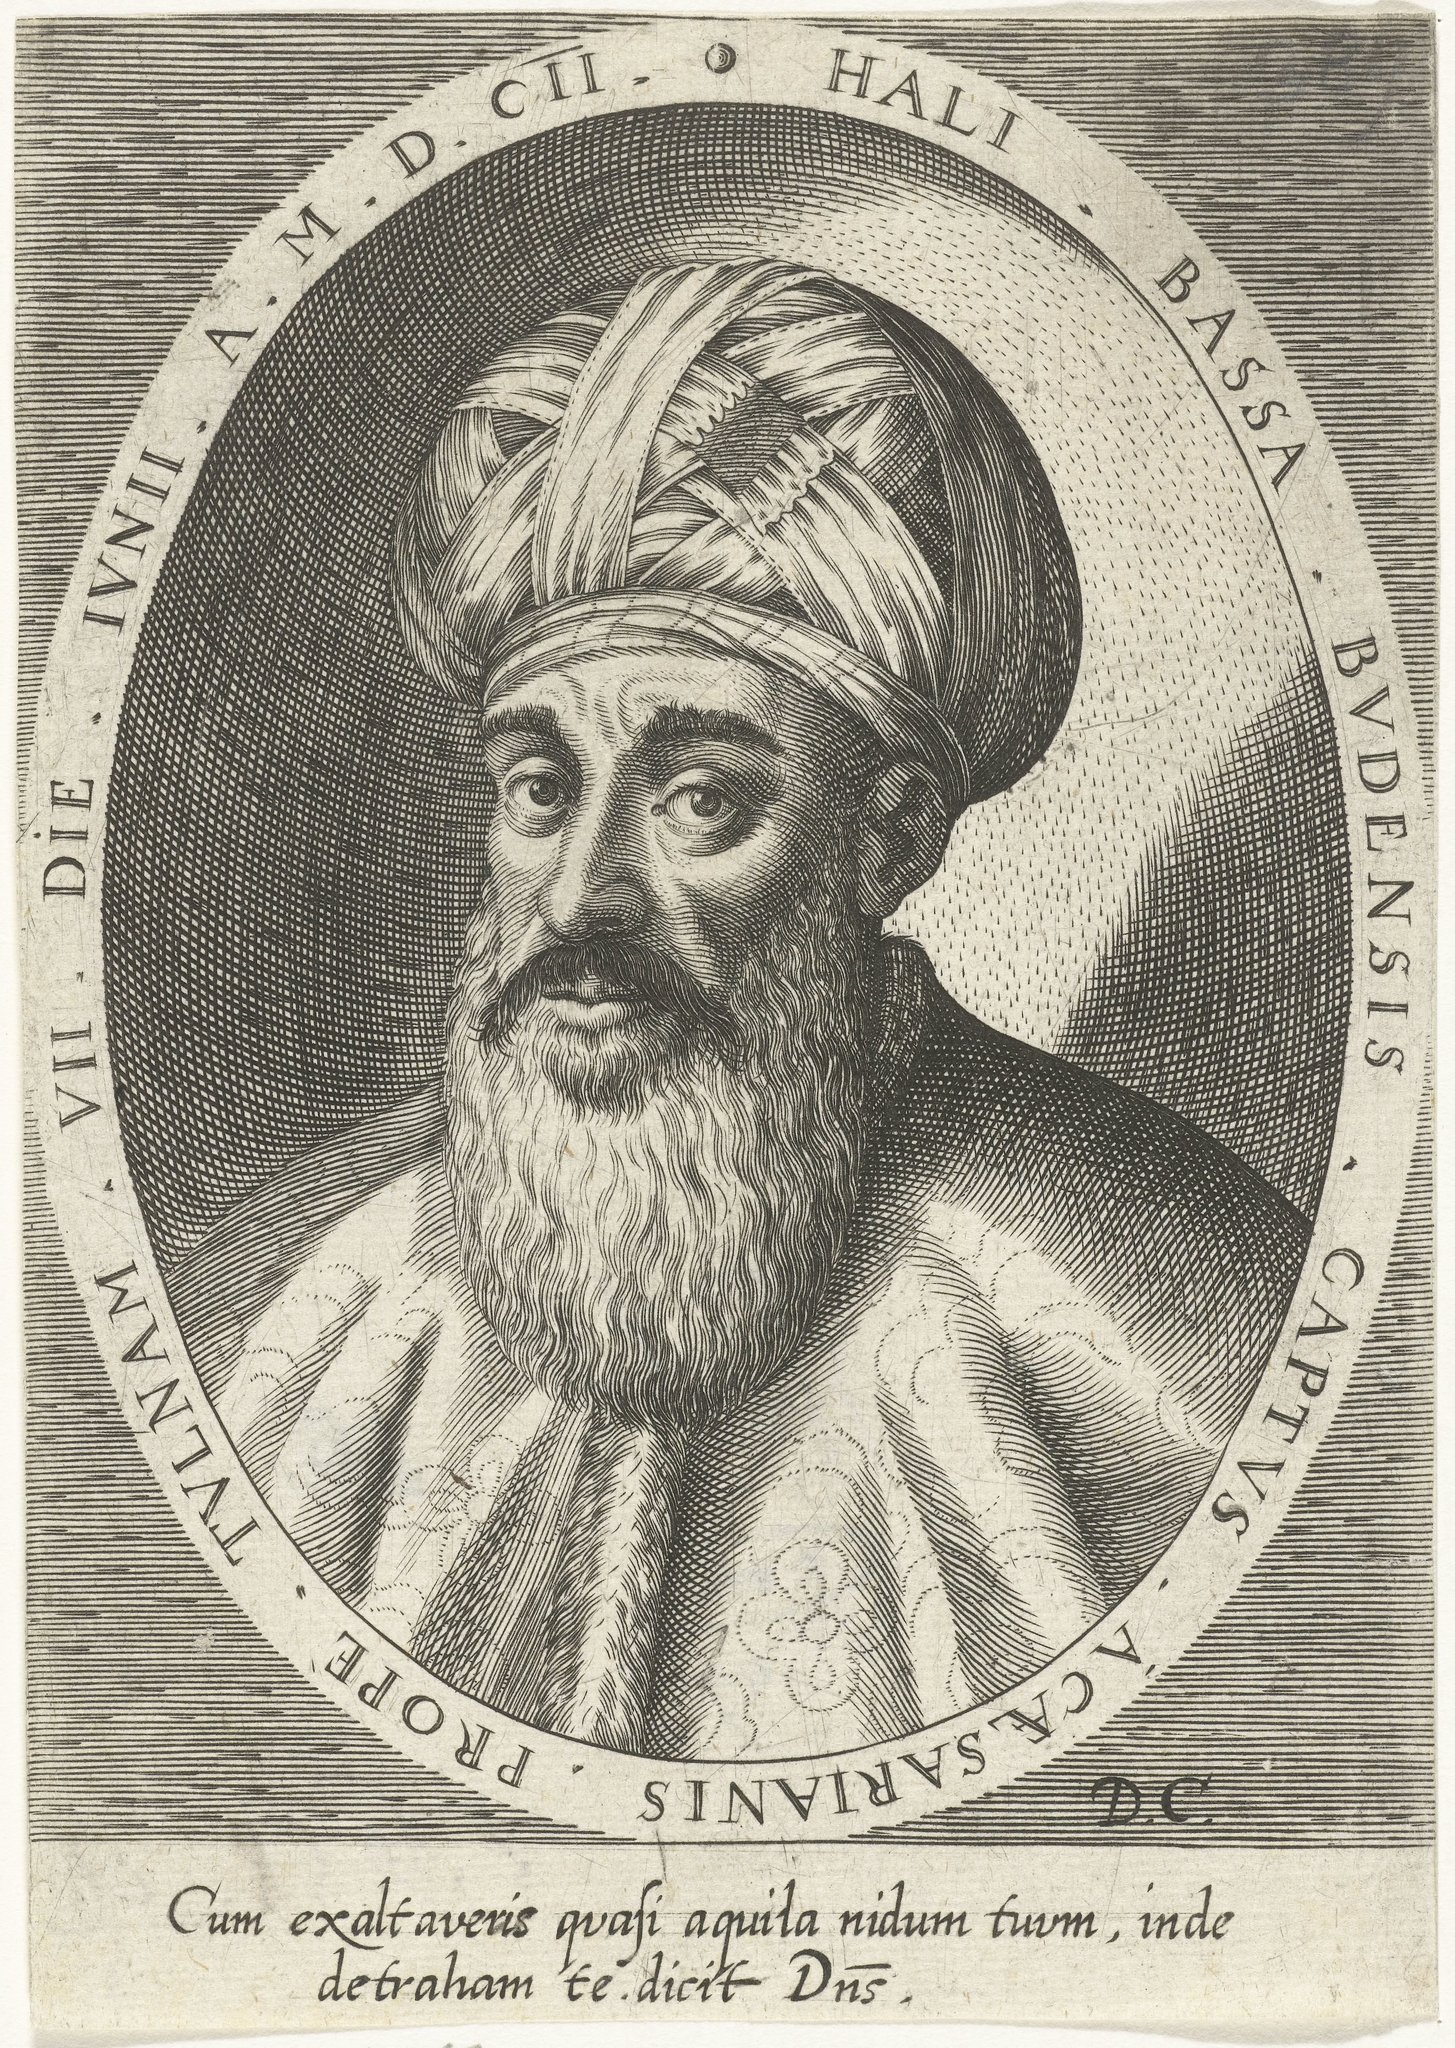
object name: print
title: Portret van de Turkse generaal Ali-Bassa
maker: dominicus custos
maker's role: print maker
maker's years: 1560-1615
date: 1579-1615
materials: paper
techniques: engraving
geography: augsburg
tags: ali-bassa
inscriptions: collector's mark: Lugt 358, collector's mark: Lugt 2228